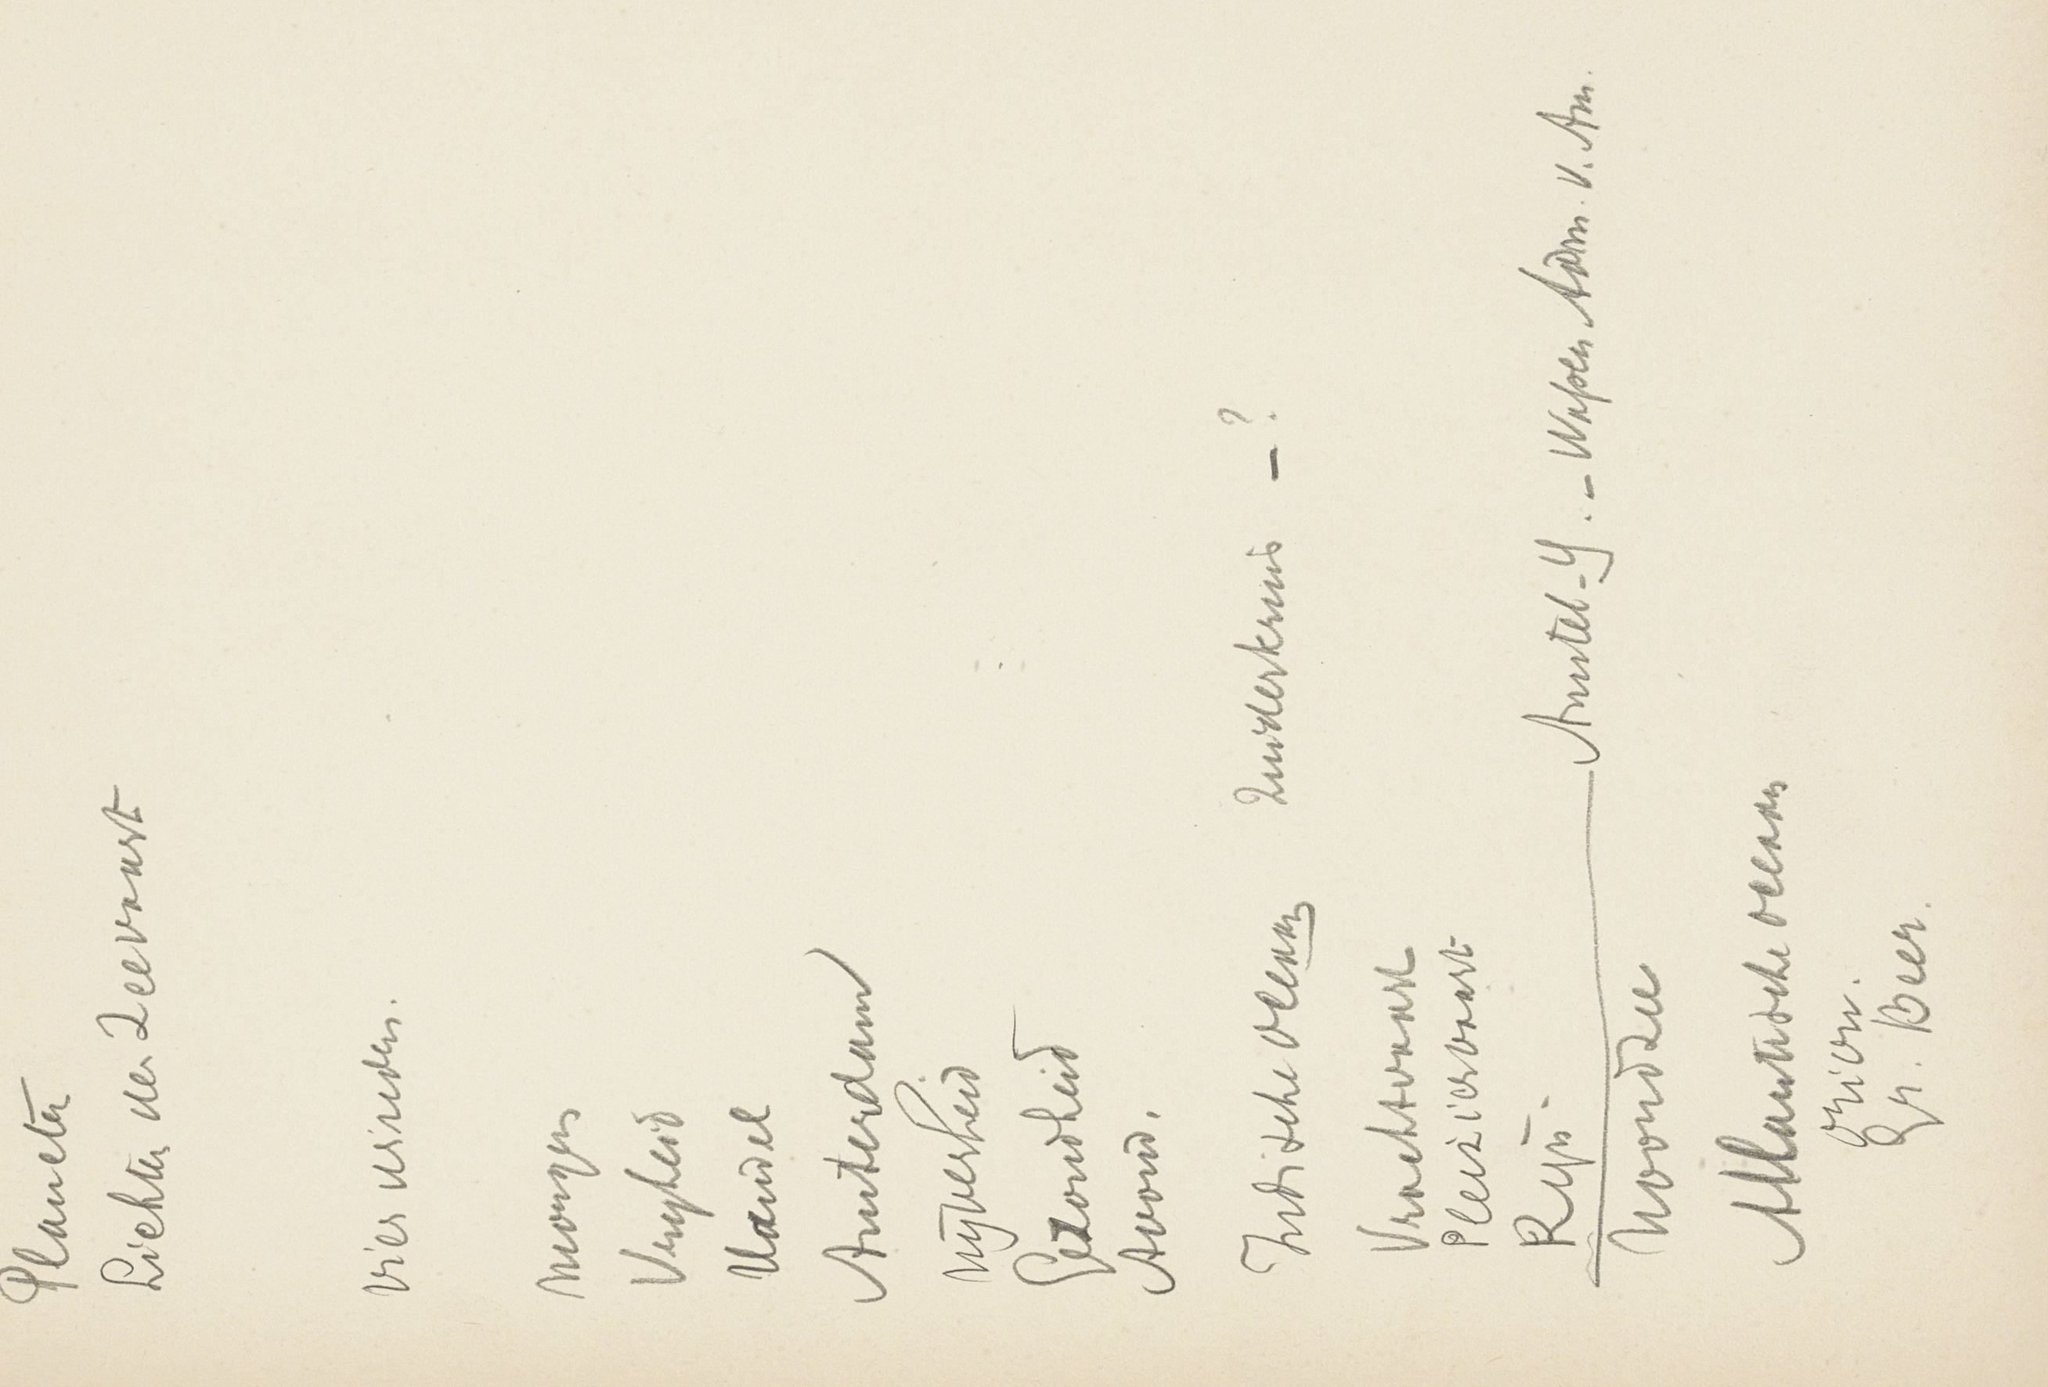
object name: sketchbook leaf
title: Notities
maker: antoon derkinderen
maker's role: draughtsman, painter, print maker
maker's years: 1859-1925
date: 1900-1903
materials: paper, pencil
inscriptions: annotation: ‘Dieren riem + zonnescepter & maan-hoorn/ Planeten/ Lichten der Zeevaart/ vier winden/ [...]’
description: Blad 39 recto uit een schetsboek met 45 bladen.